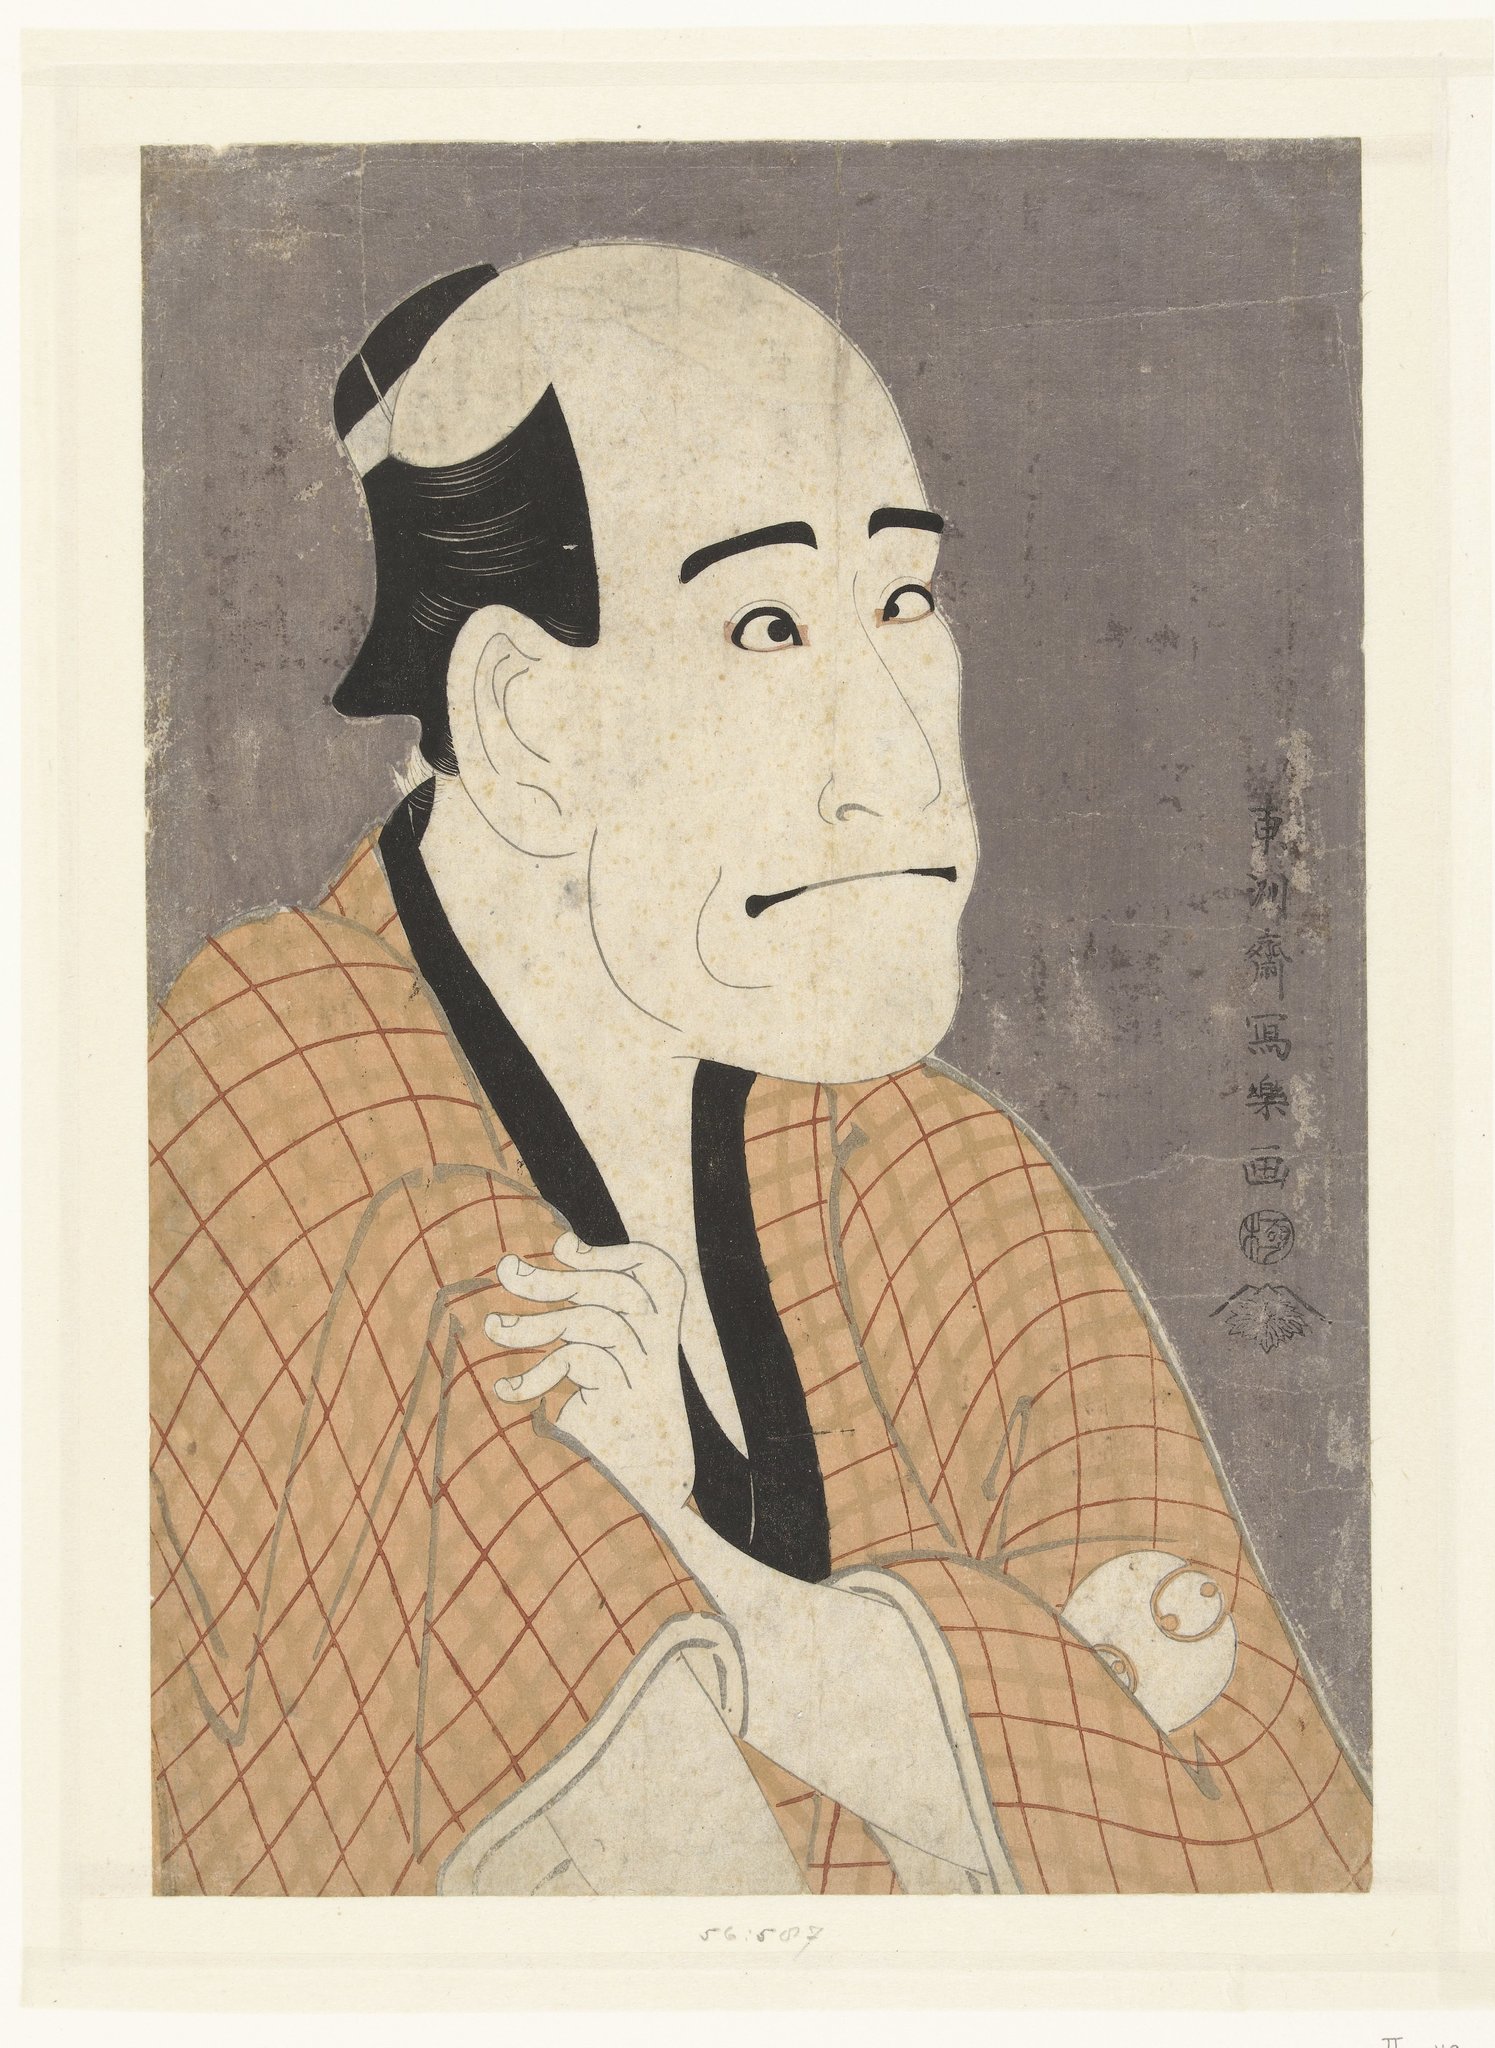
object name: print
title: Busteportret van Arashi Ryuzo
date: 1794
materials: paper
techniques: woodcut, nishiki e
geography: tokyo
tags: portrait of actor, actress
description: De acteur Arashi Ryuzo in de rol van de boosaardige geldschieter Ishibe no Kinkichi, in oranje geruite kimono, zijn mouw opstropend; tegen grijze mica achtergrond. Scene uit het toneelstuk Hana ayame Bunroku Soga, opgevoerd in het Miyako-za in 1794.